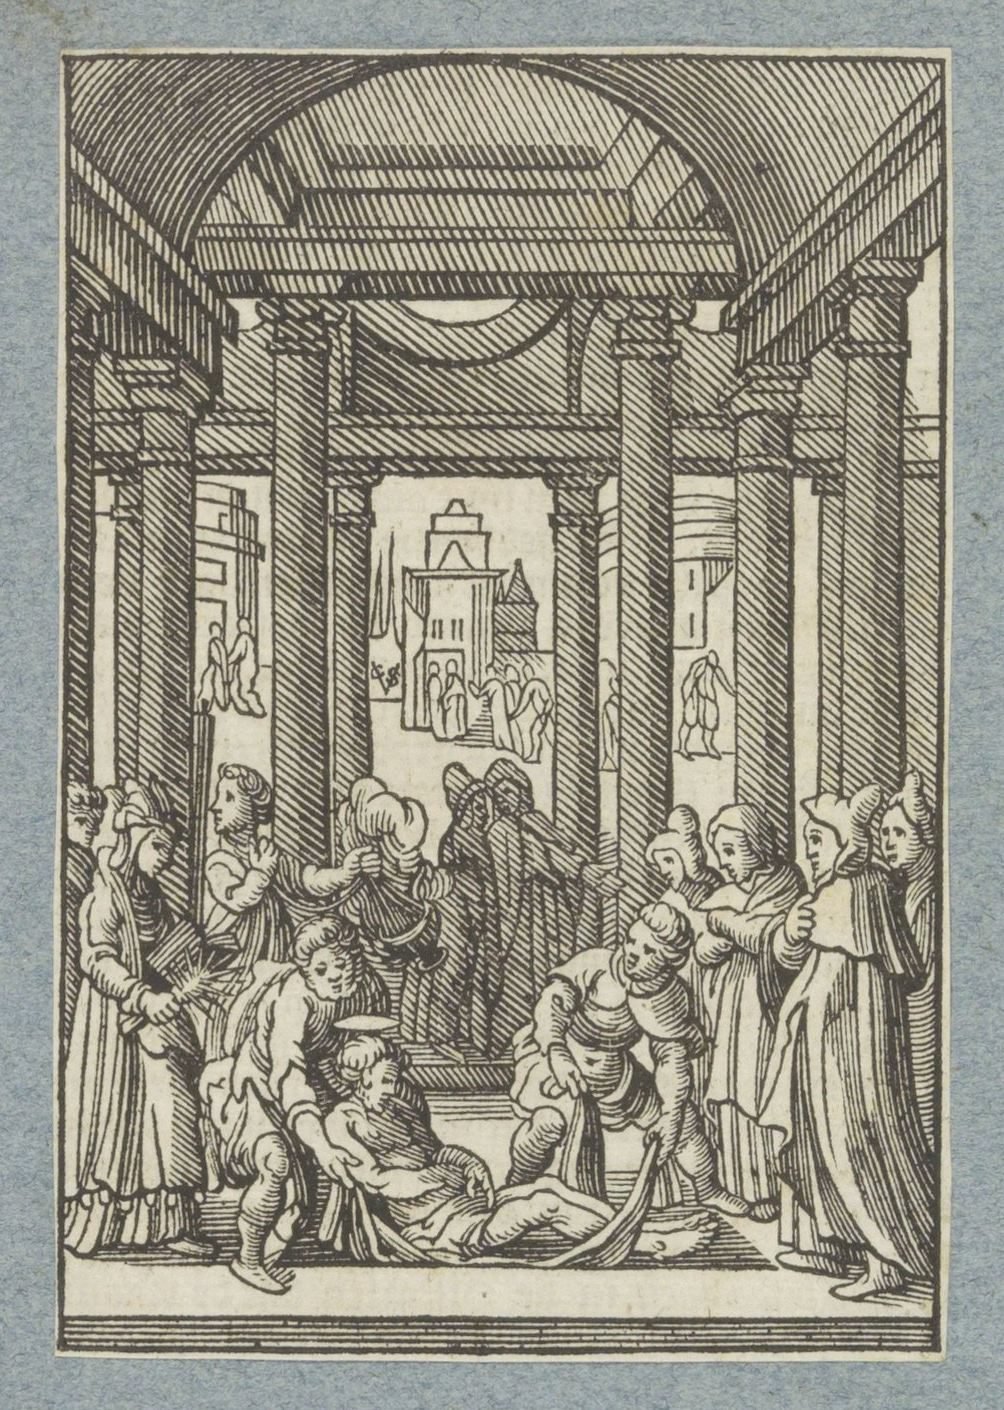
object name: book illustration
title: Graflegging van Stefanus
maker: pieter jacobsz. paets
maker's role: publisher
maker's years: 1587-1667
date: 1629-1646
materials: paper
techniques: letterpress printing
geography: haarlem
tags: burial of stephen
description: De prent is afkomstig uit een van de uitgaven van P.J. Paets uit Amsterdam. De prent wordt mogelijk al gebruikt in: Der Zielen Lust-hof. Leuven, I.Jacbosz voor P.J. Paets [= Amsterdam, P.J. Paets], 1629. Ze komt in ieder geval voor in: Het Nieuwe Testament ons Salichmaeckers Jesu Christi. Amsterdam, P.J. Paets, 1646. De voorstelling is gekopieerd naar een prent van Philips Galle naar Maarten van Heemskerck, onderdeel van de serie getiteld Acta Apostolorum.